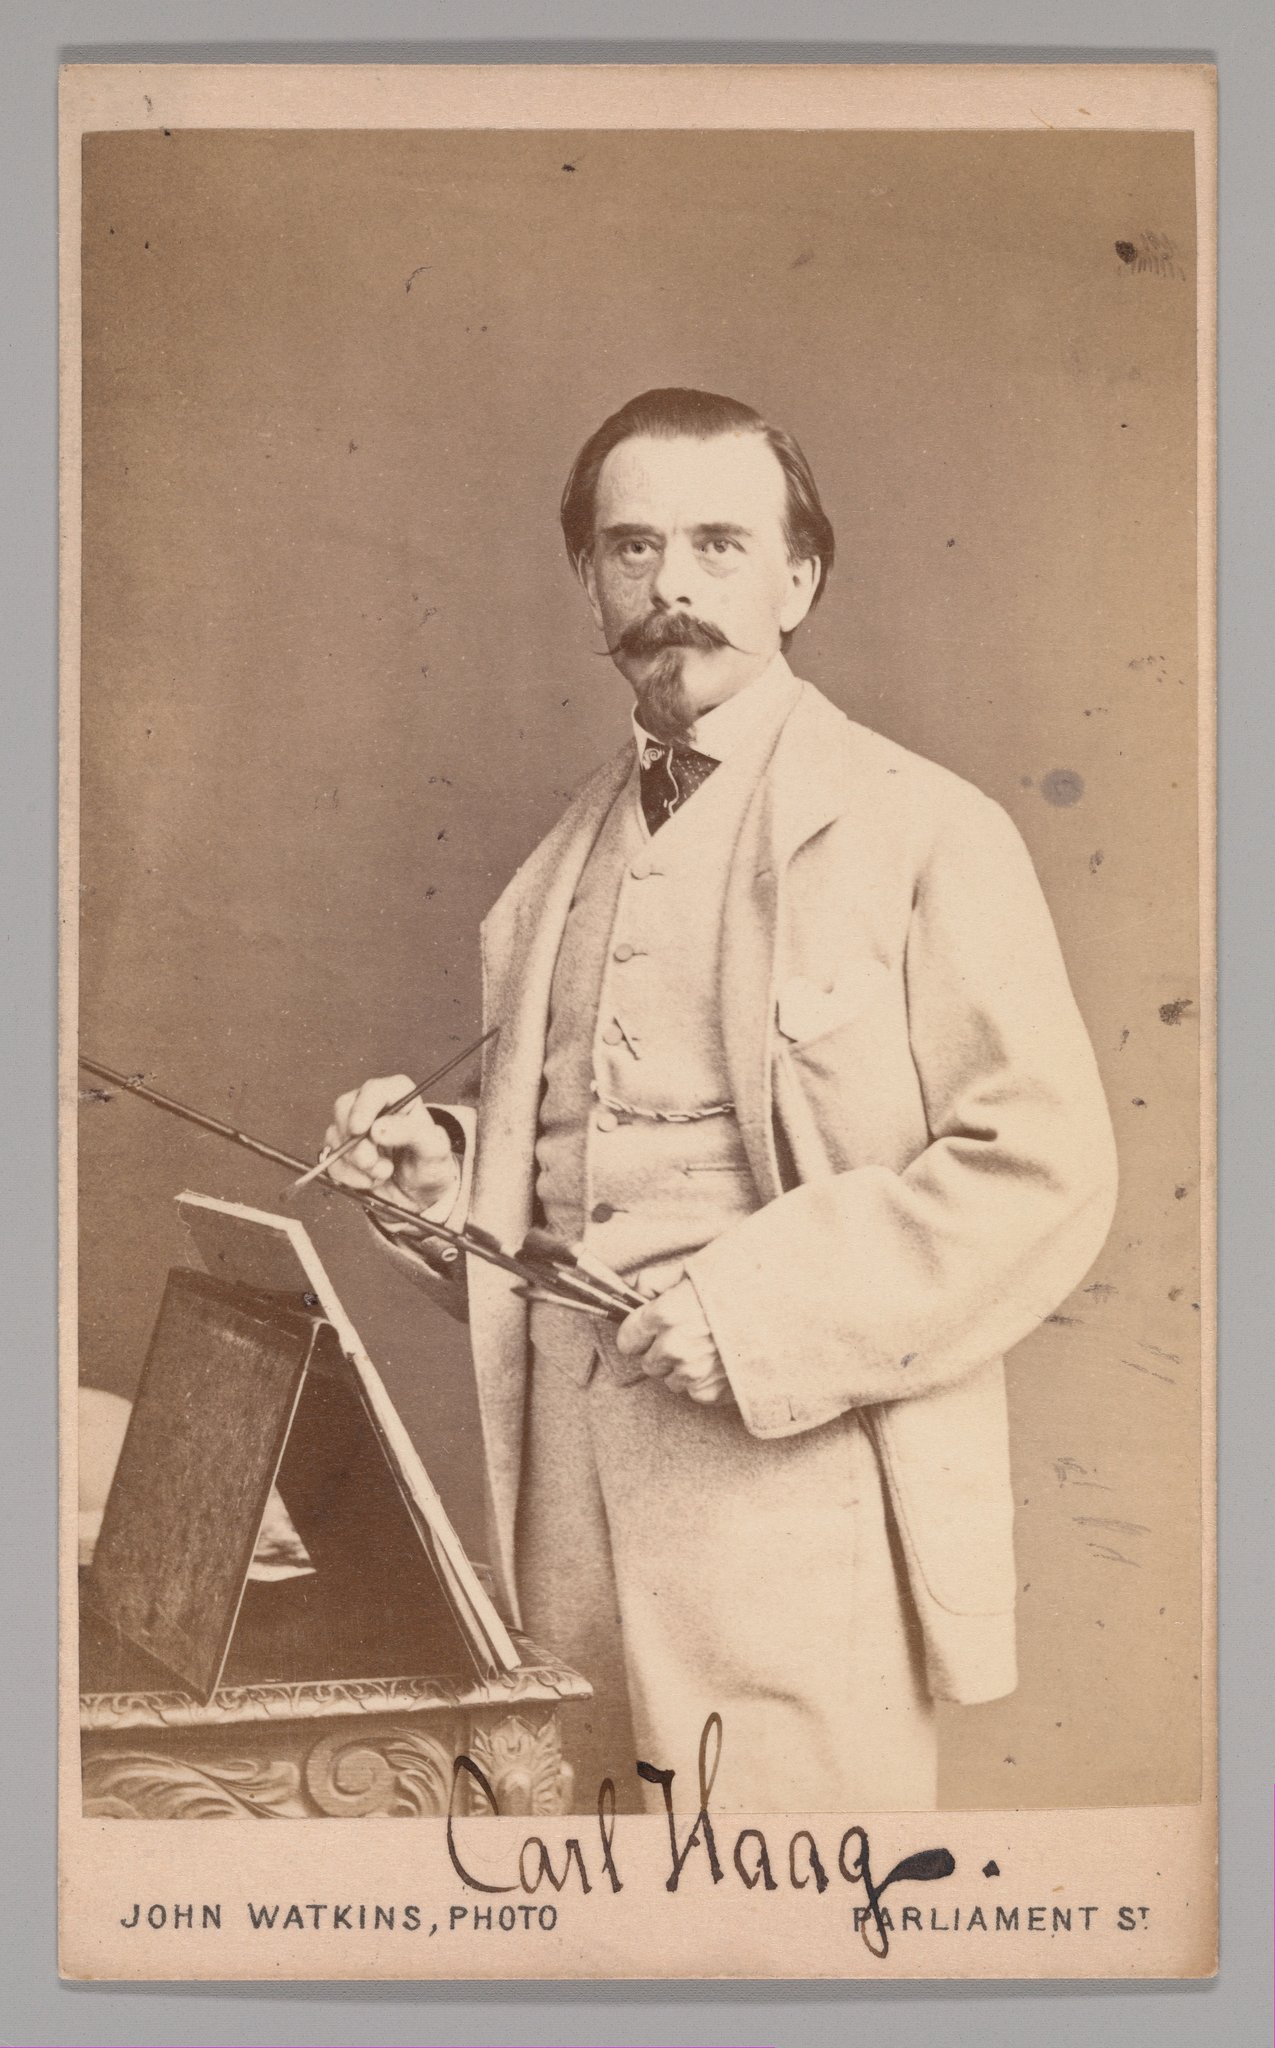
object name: carte de visite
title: [Carl Haag]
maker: john and charles watkins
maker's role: photography studio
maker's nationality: british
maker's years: 1840-1875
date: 1860-1869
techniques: albumen silver print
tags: men,portraits